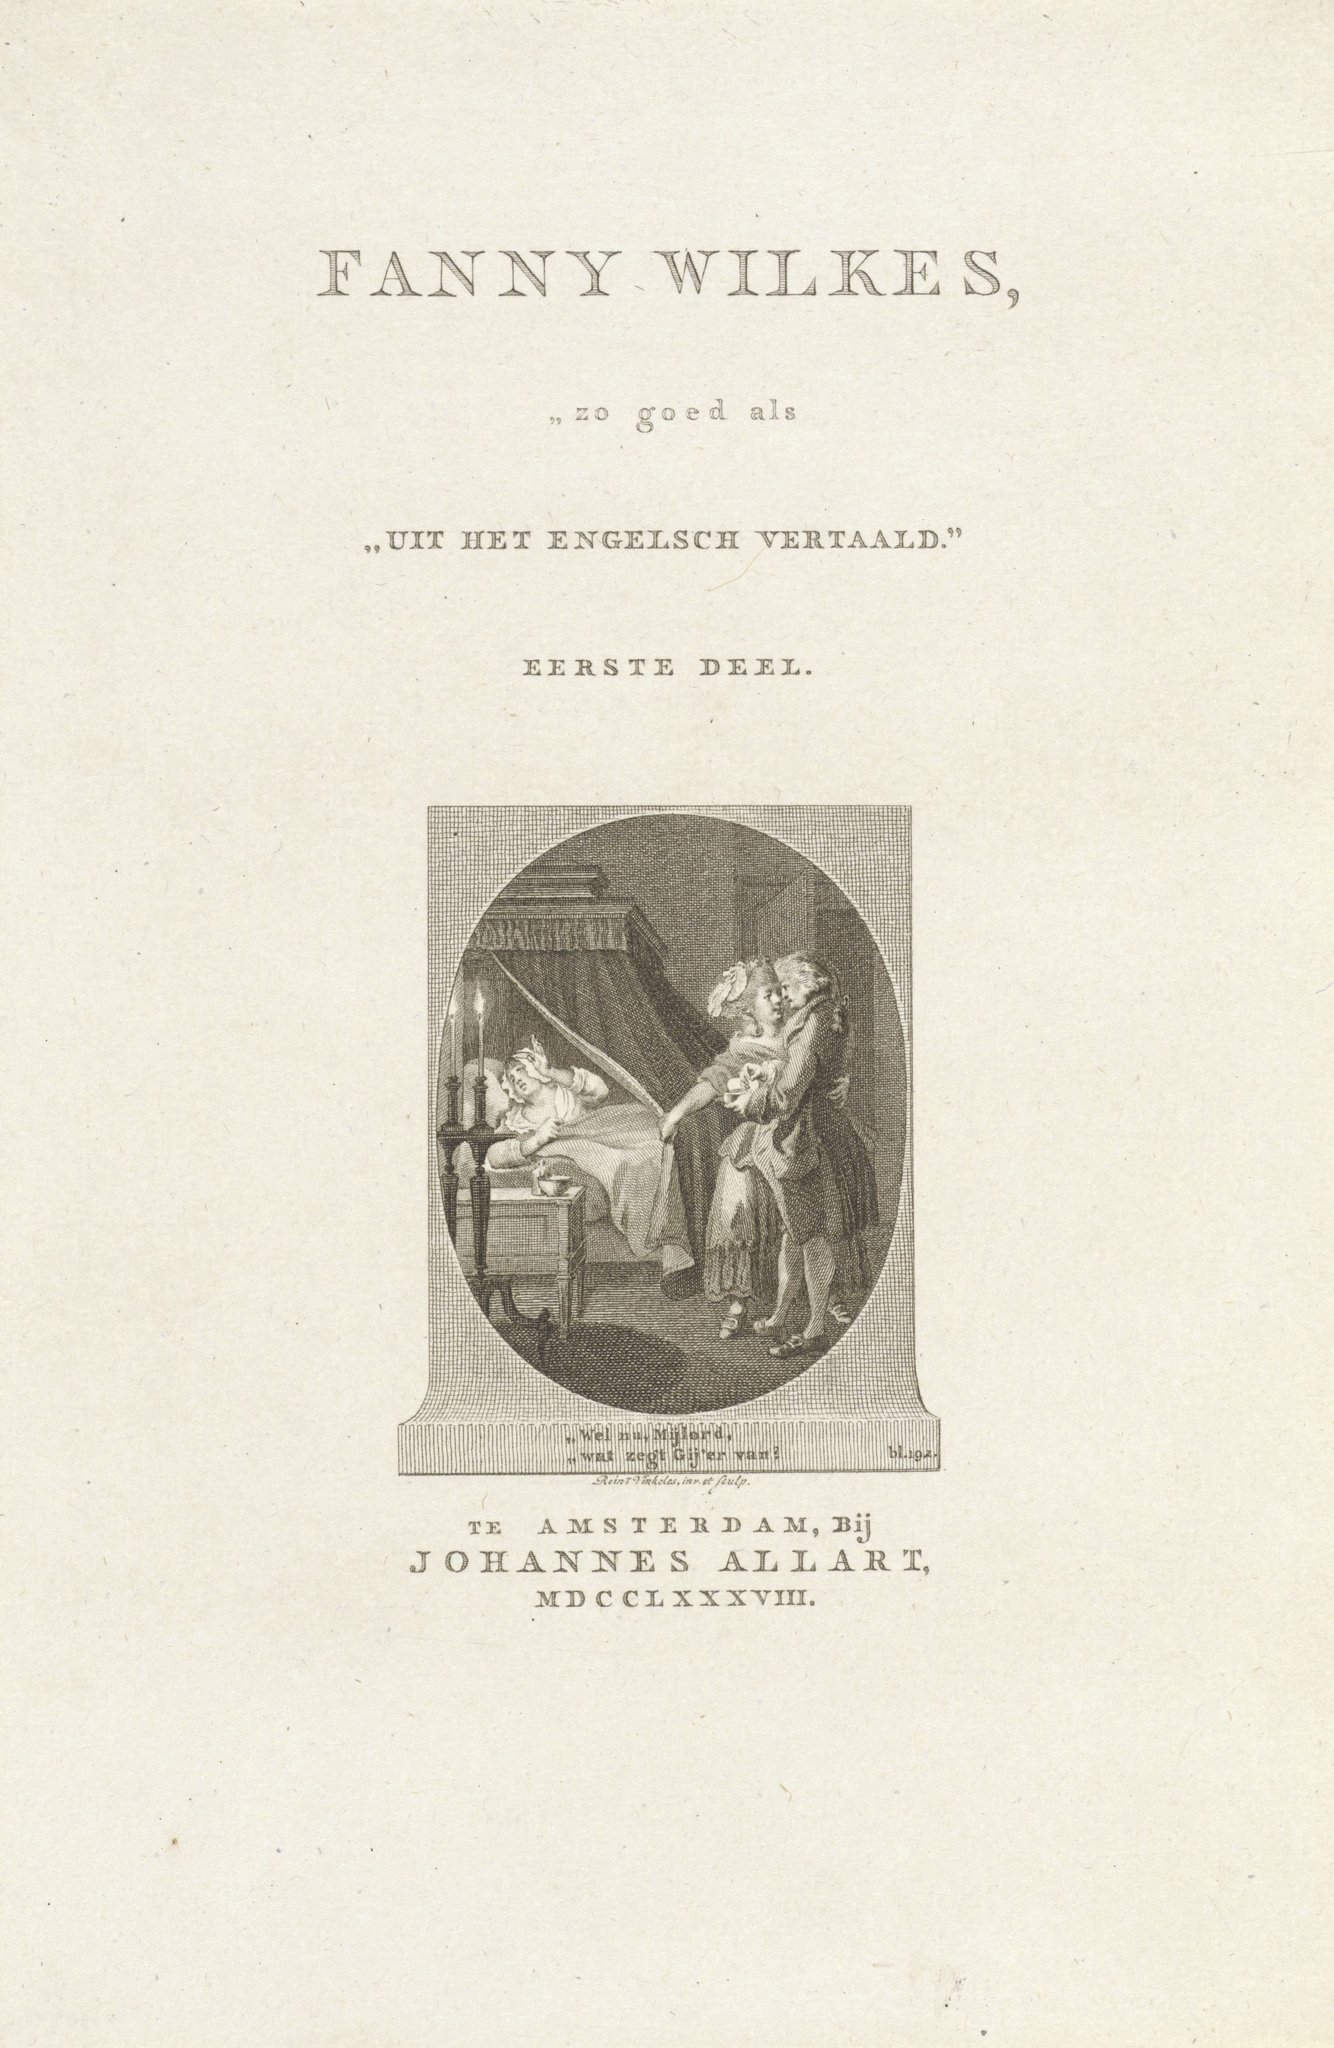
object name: print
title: Titelpagina voor: 'Fanny Wilkes', 1788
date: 1788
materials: paper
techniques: engraving, etching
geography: amsterdam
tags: (lovers) embracing each other, 'symplegma', bed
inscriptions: collector's mark: Lugt 240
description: Titelpagina met een minnend paar waarvan de vrouw een gordijn van het hemelbed naast hen opent. De dame die in bed ligt kijkt geschrokken op.